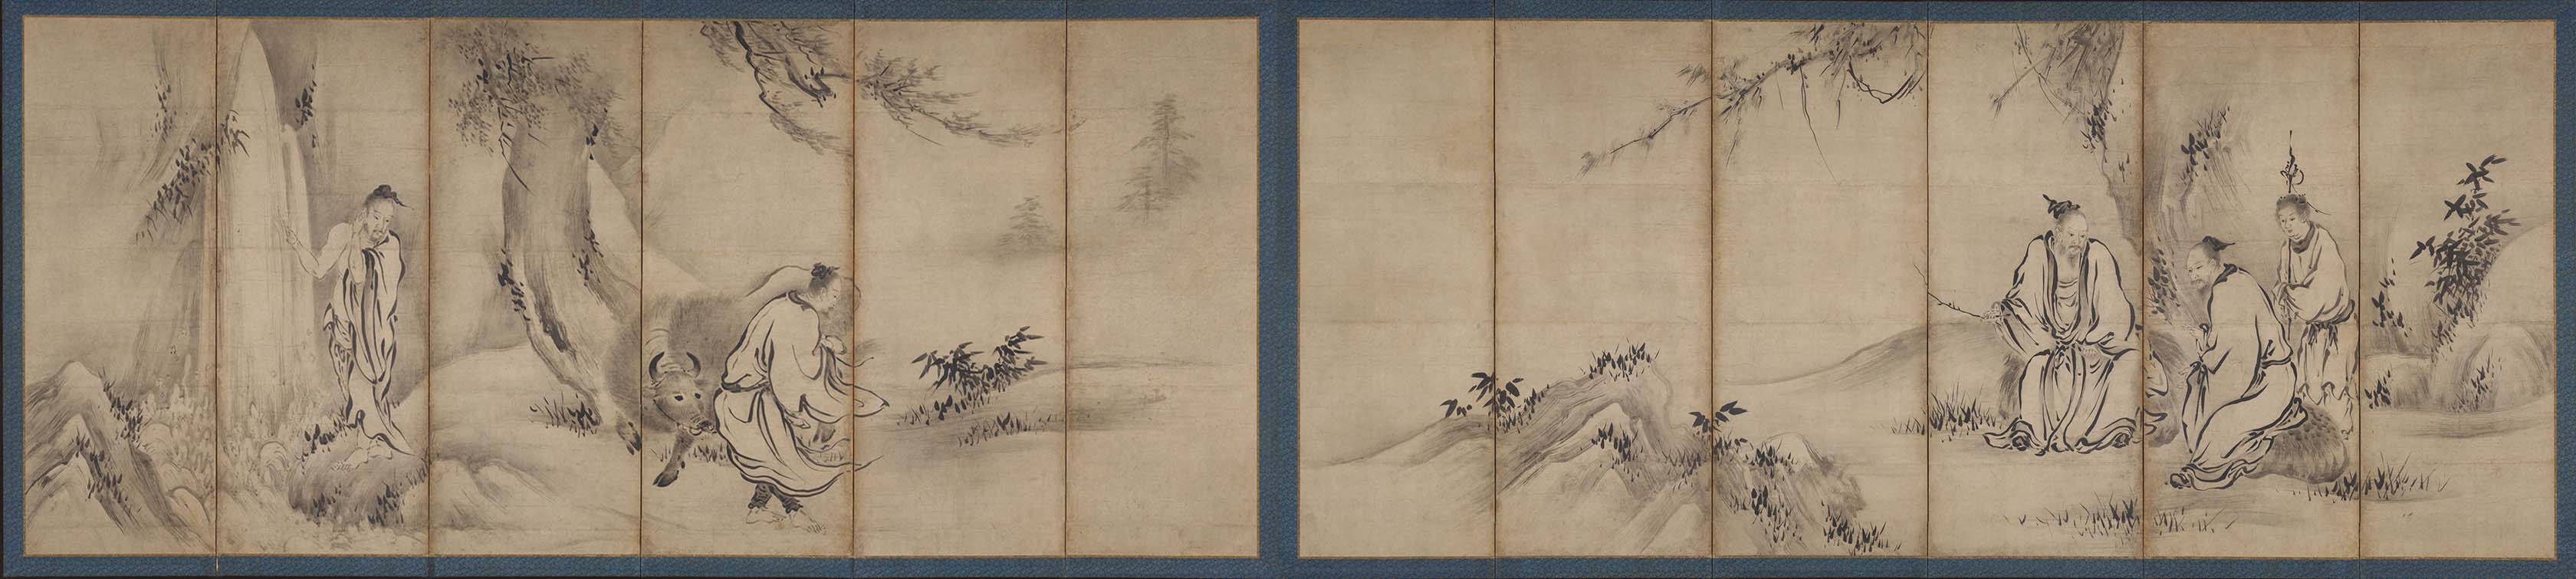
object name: screen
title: Chinese Sages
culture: japanese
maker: kano sanraku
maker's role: artist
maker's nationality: japanese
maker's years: 1559-1635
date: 1567-1633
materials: ink, panel, paper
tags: men